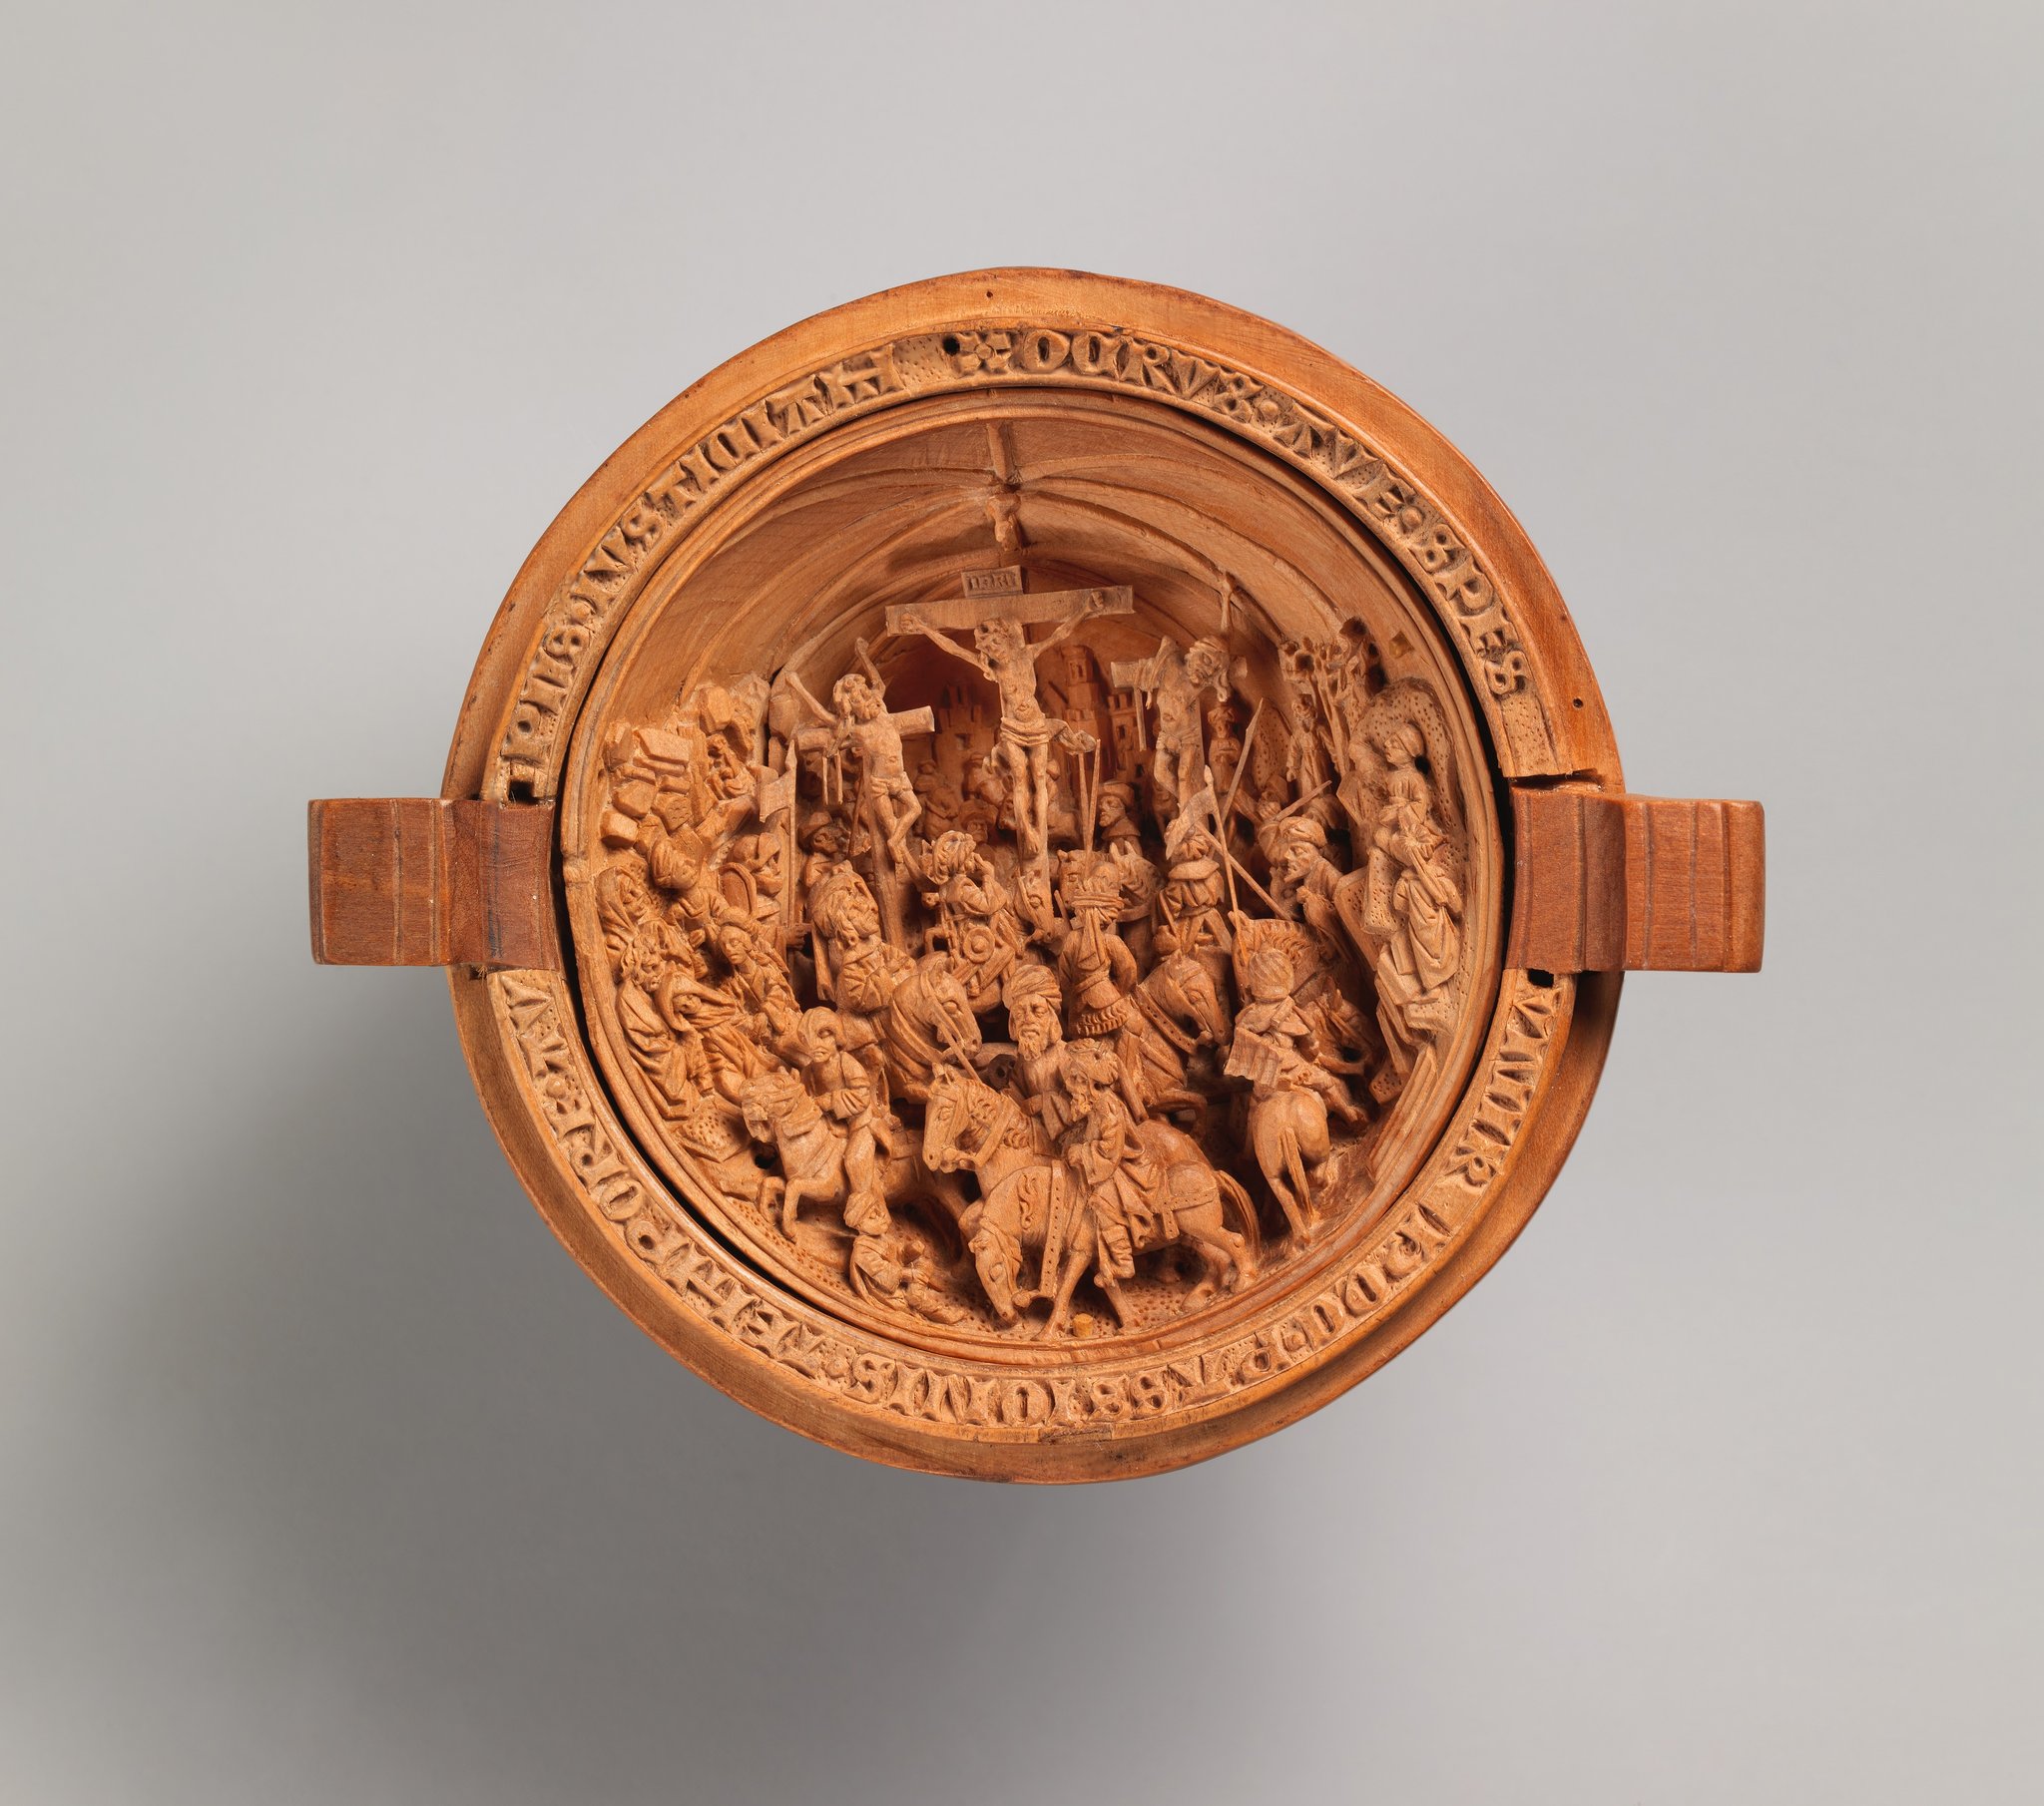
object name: rosary bead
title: Half of a Prayer Bead with the Crucifixion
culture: dutch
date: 1501-1533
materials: wood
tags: horses,jesus,crucifixion